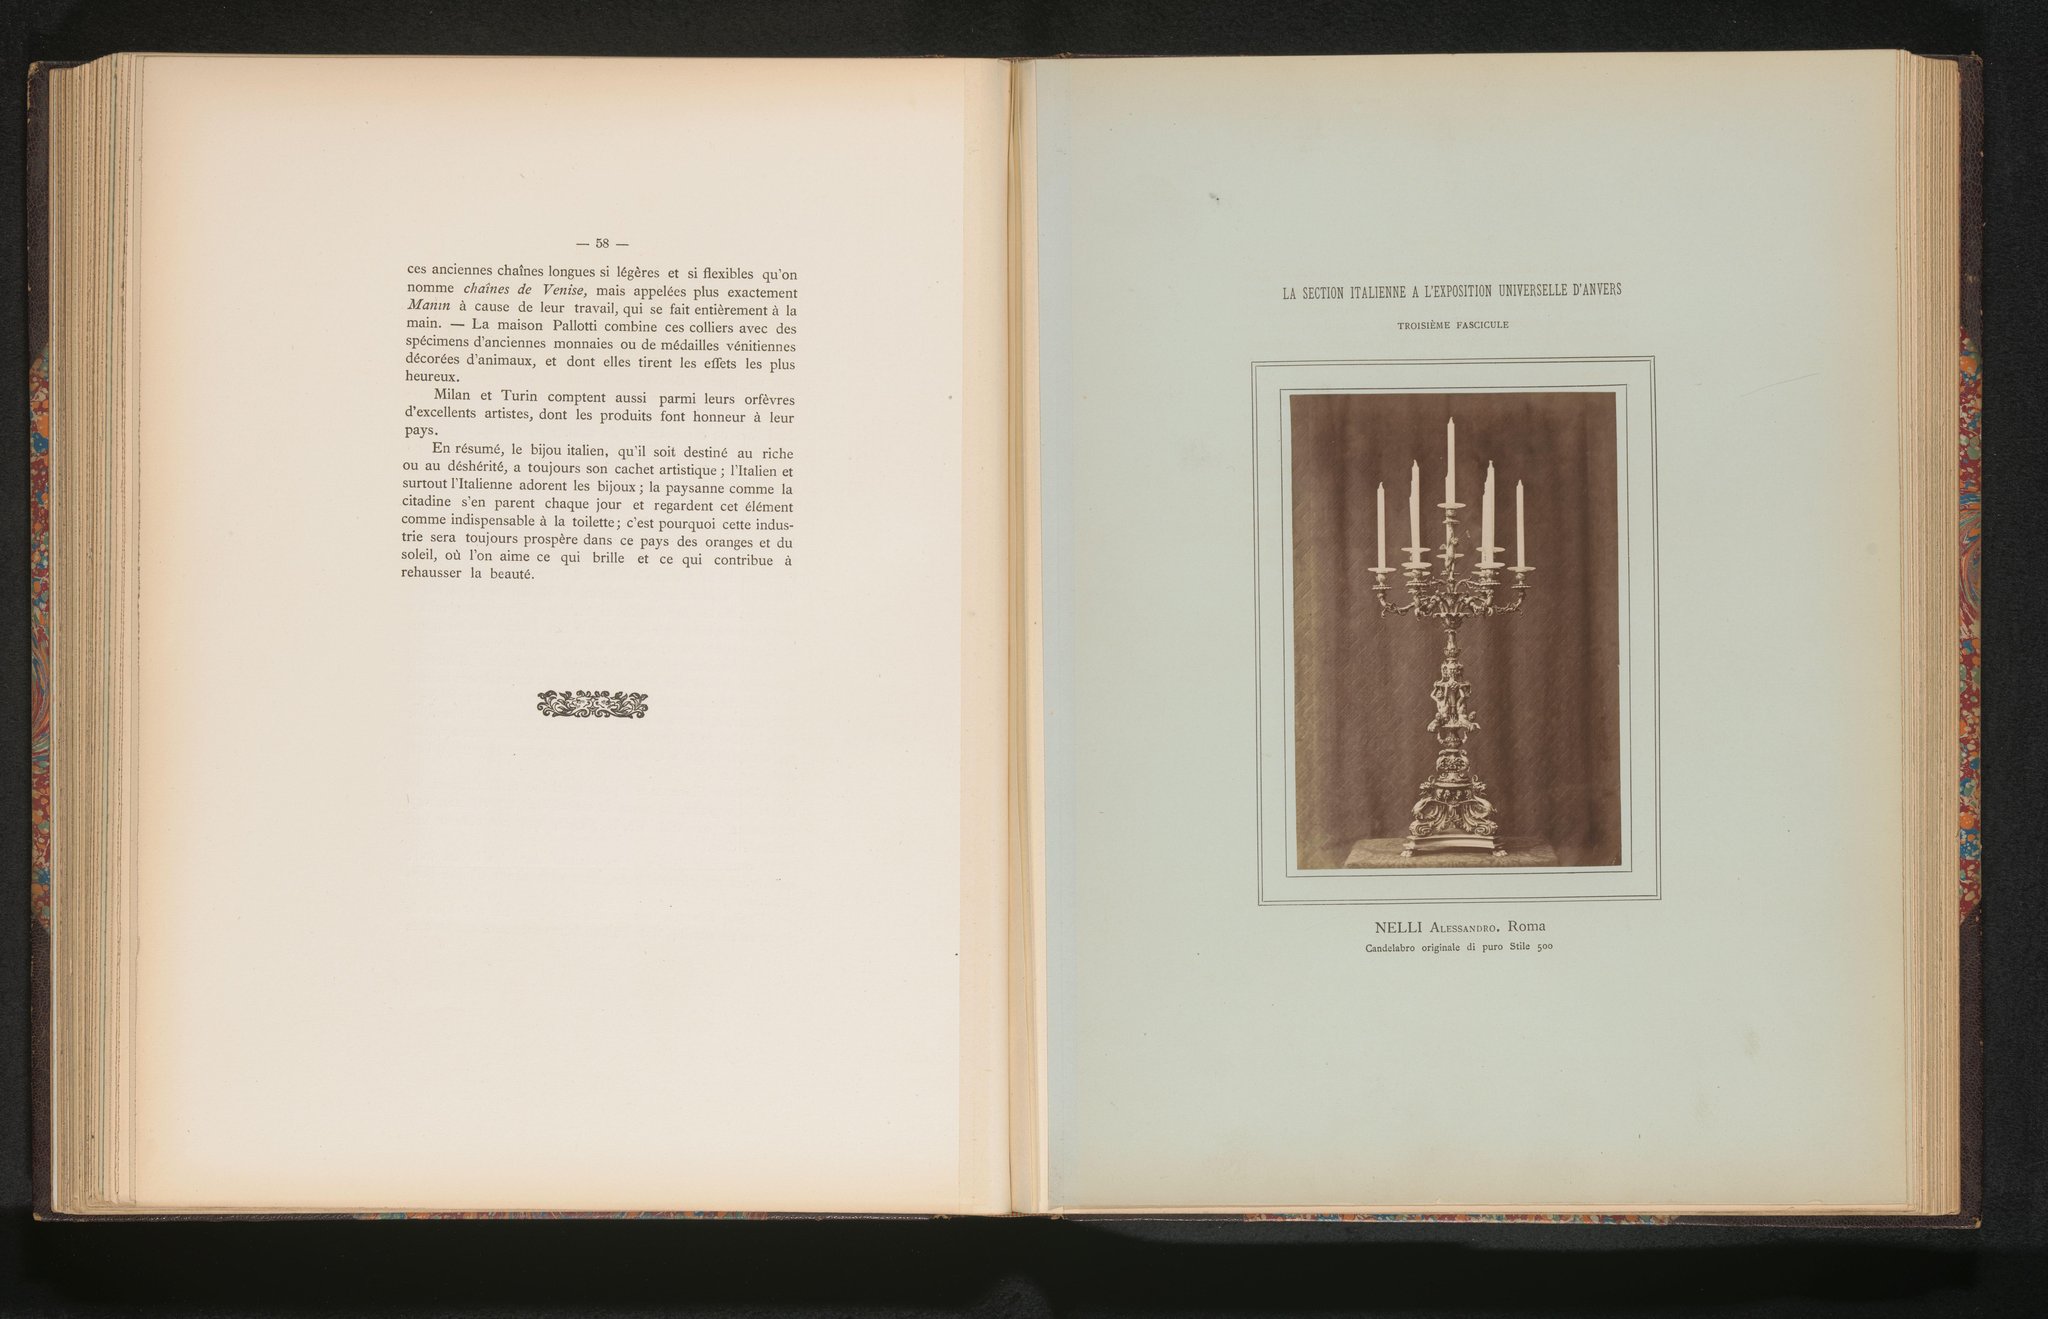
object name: page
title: Kandelaar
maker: Anonymous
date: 1880-1885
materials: photographic support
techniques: albumen print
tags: chandelier, candelabrum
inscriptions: inscription: ‘La section Italienne a l'exposition universelle d'Anvers/ premies fascicule’, inscription: ‘Candelabro originale di puro Stile 500’